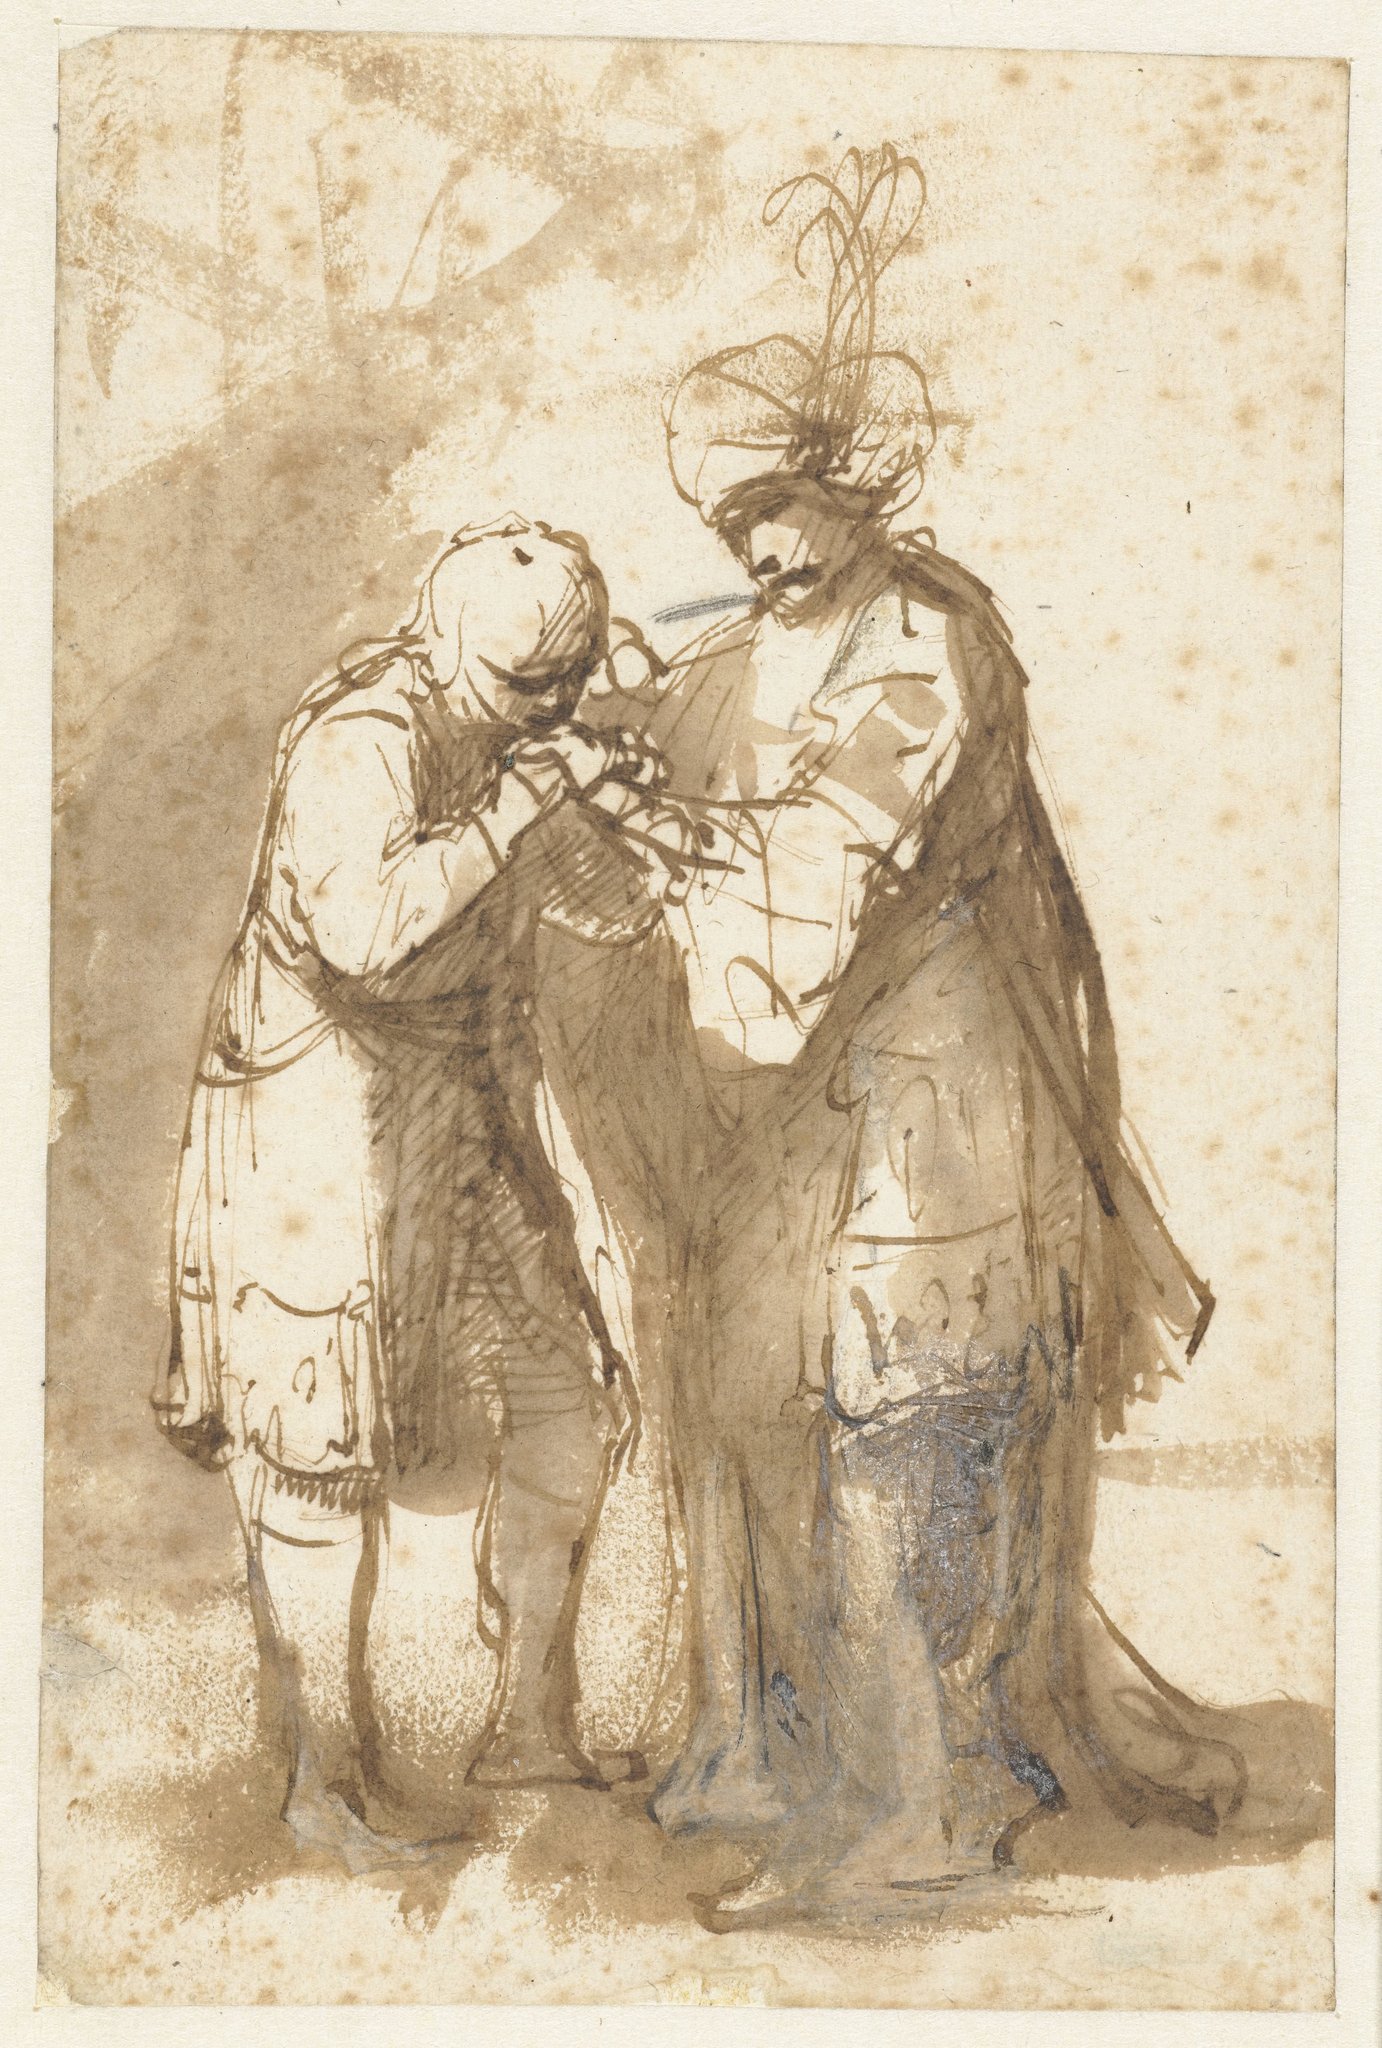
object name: drawing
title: David neemt afscheid van Jonathan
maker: ferdinand bol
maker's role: draughtsman, painter, print maker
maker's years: 1616-1680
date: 1643-1647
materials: paint, ink, paper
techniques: brush, pen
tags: david and jonathan embracing; david's leave-taking from jonathan